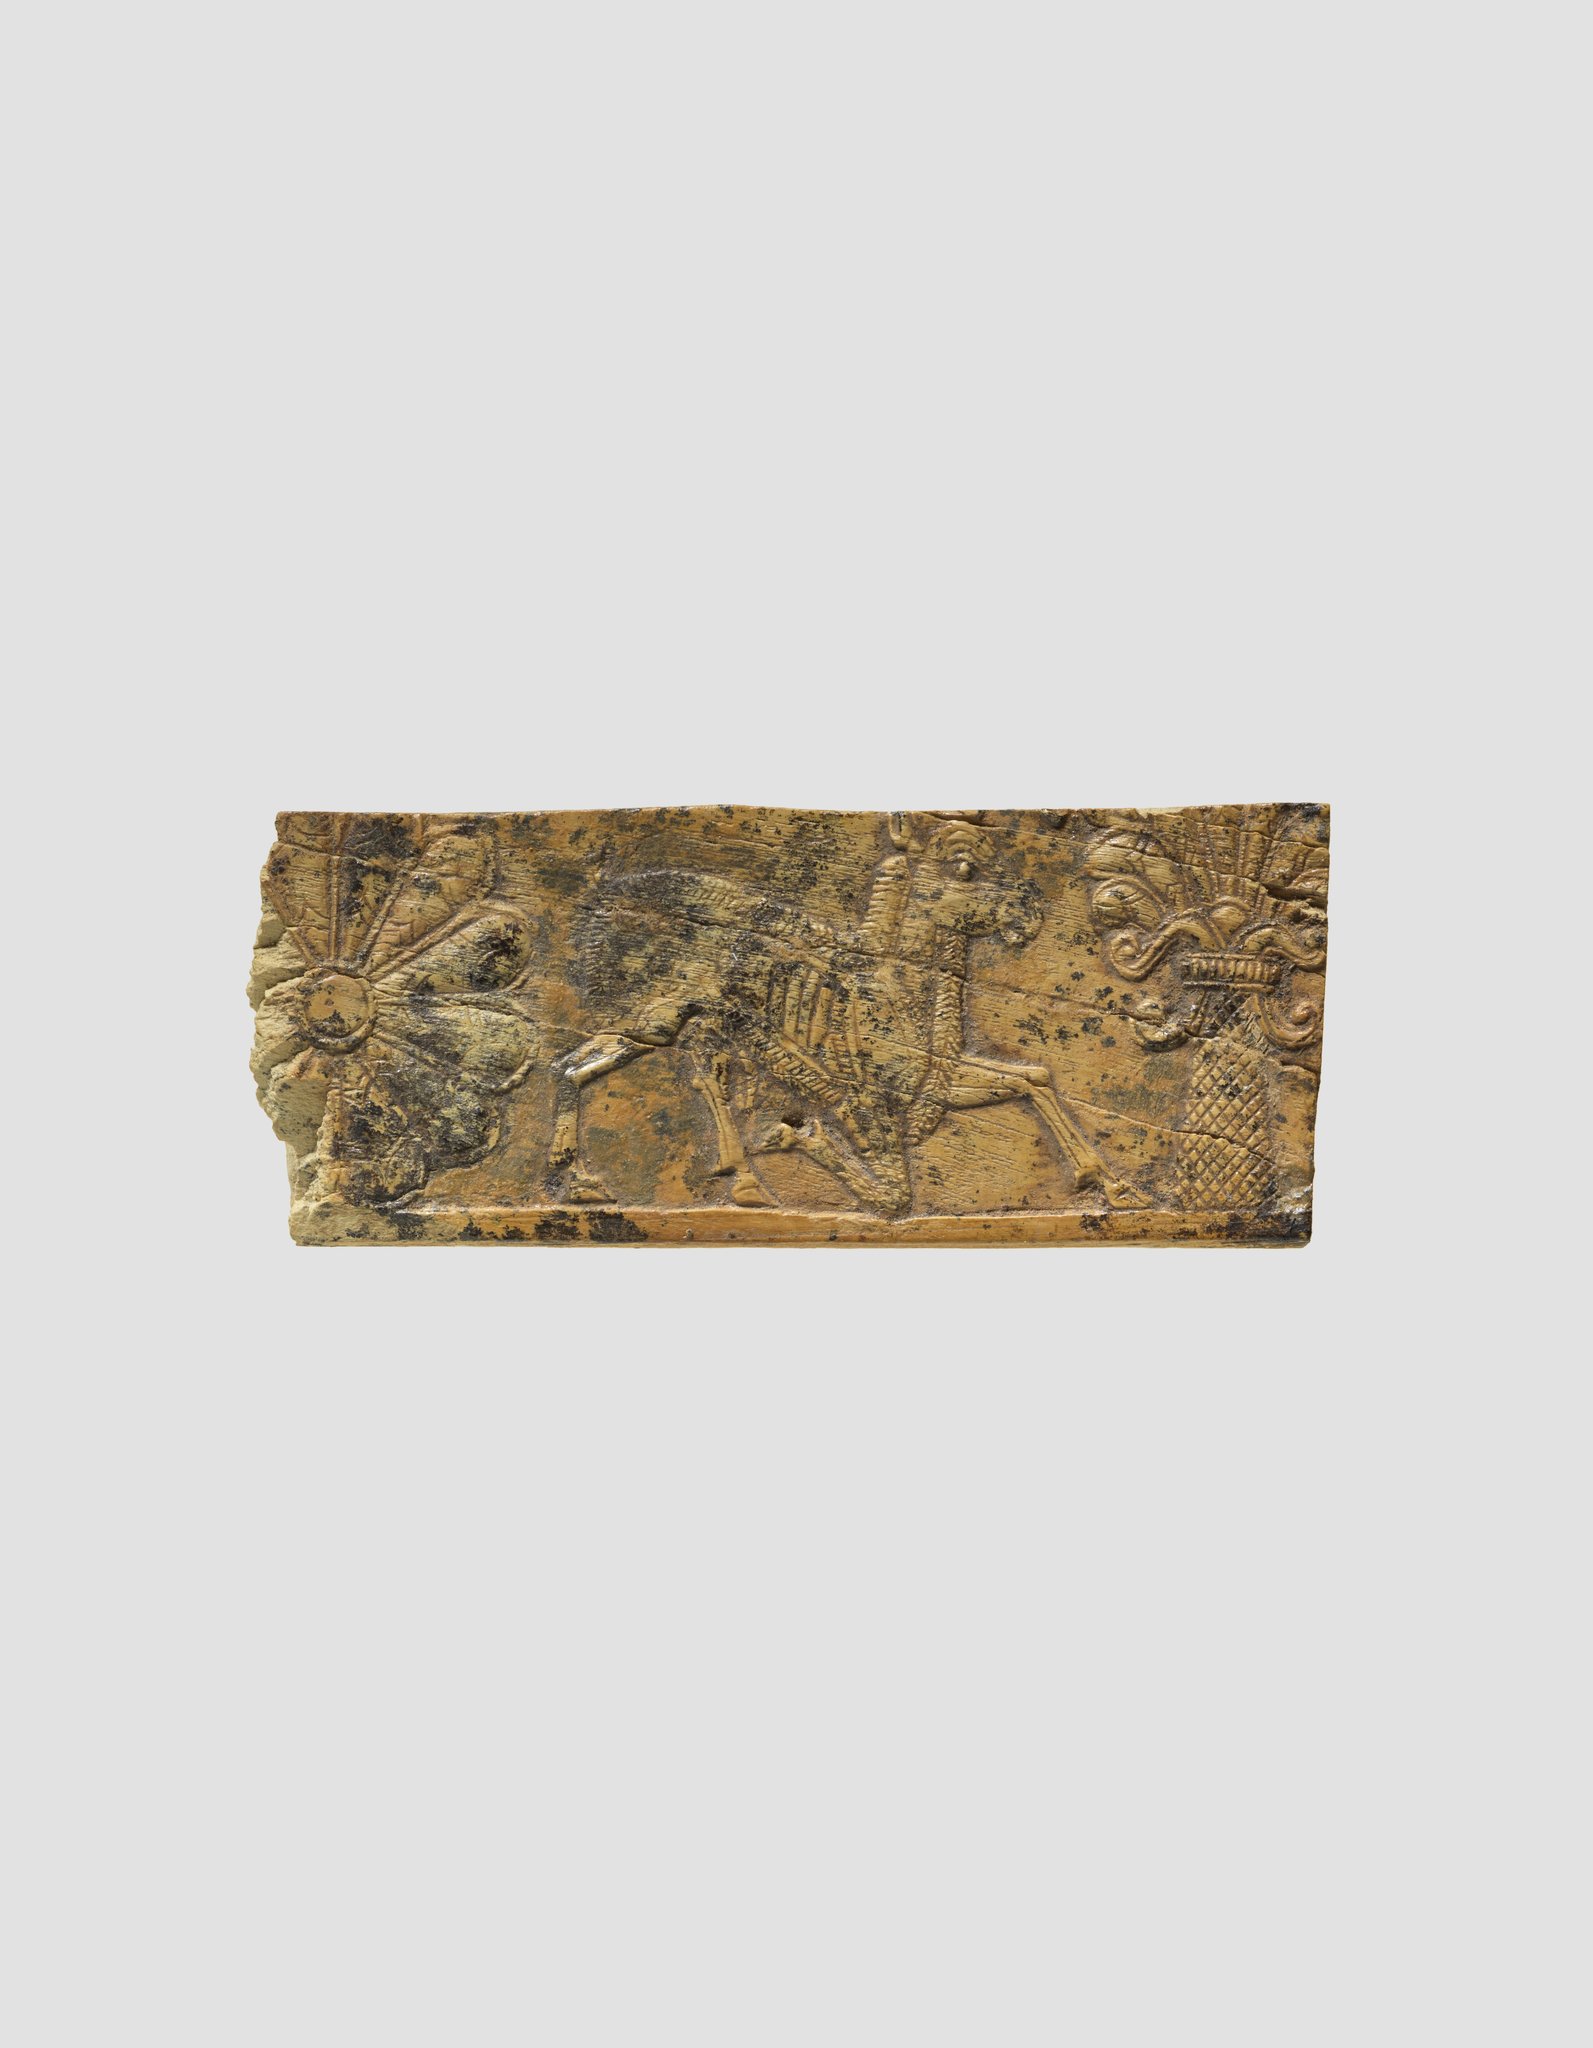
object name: relief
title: Panel fragment with a kneeling horned animal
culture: iranian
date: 800-601 BCE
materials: ivory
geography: iran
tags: animals